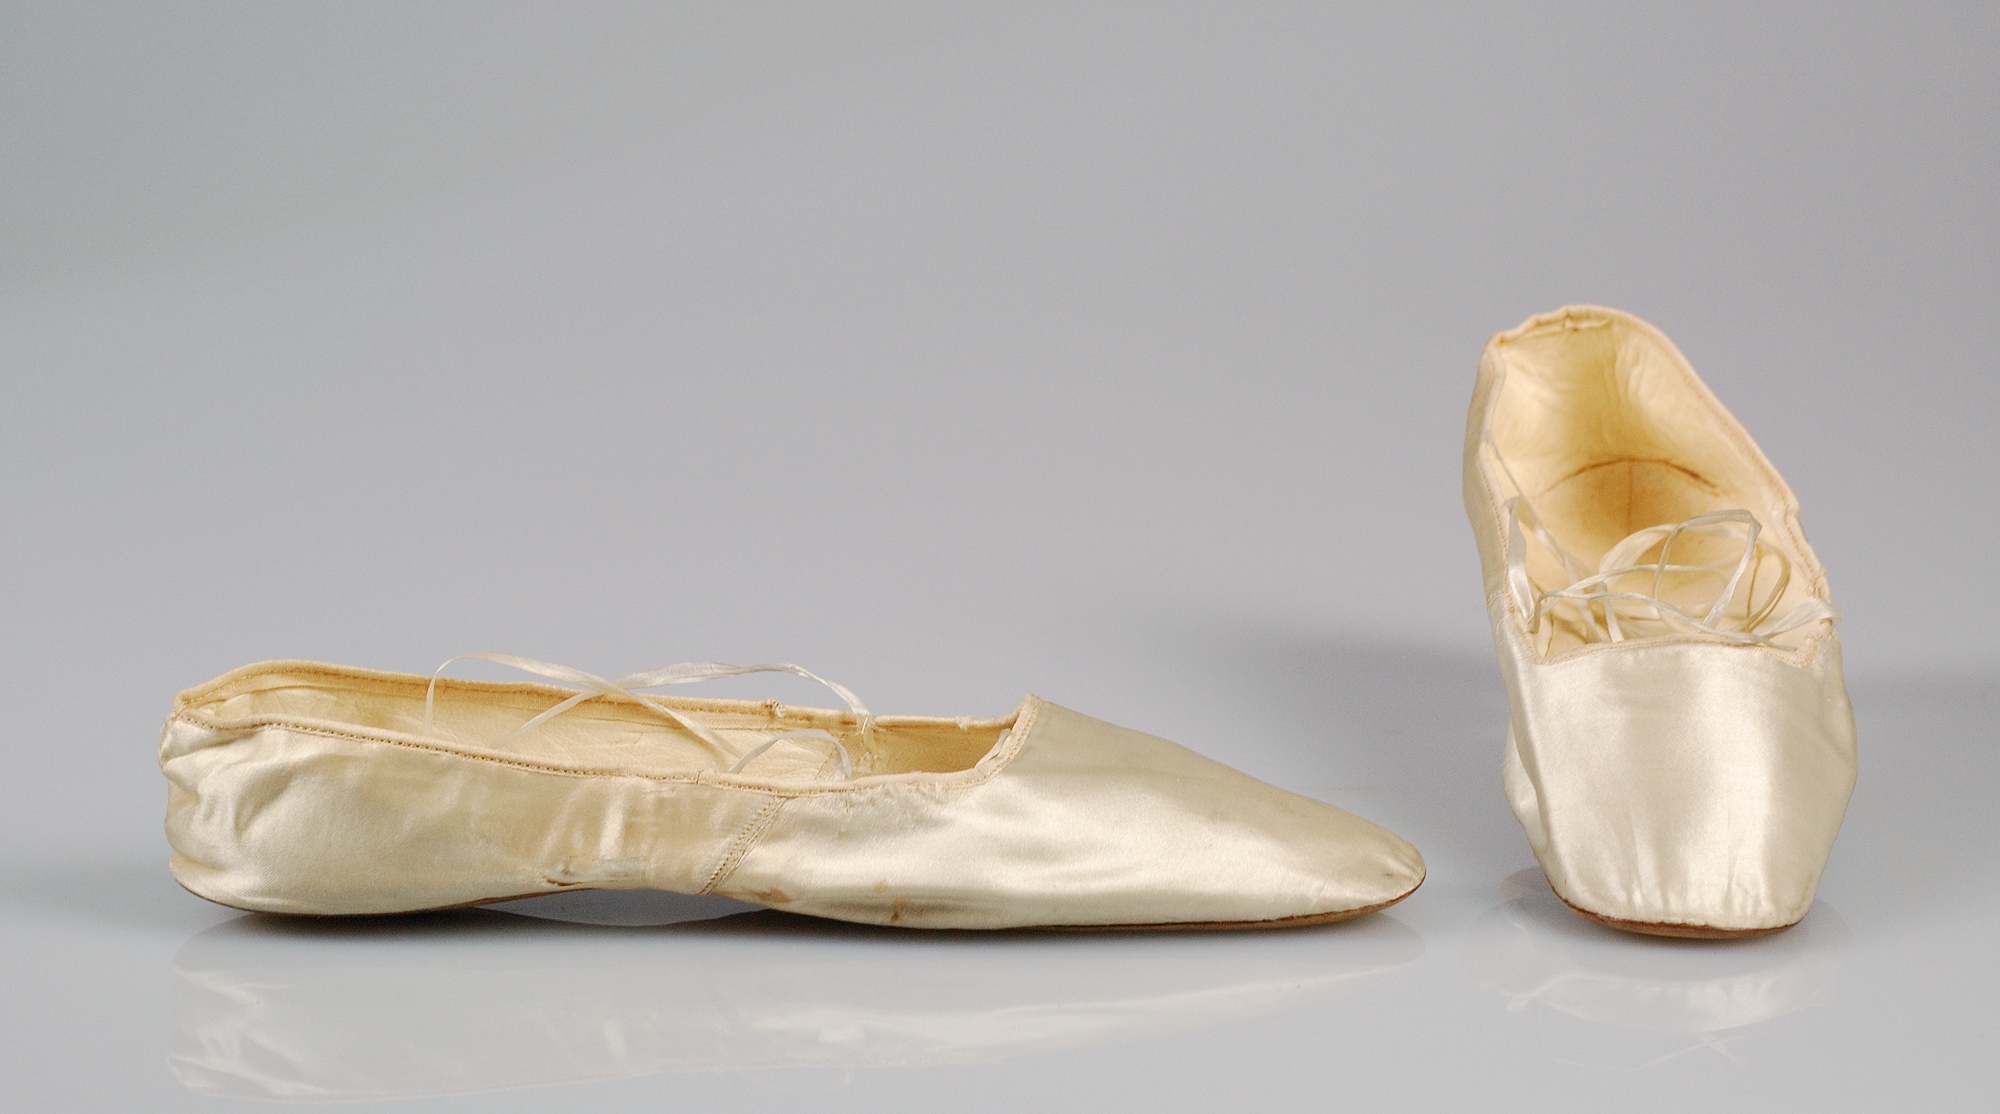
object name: wedding slipper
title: Wedding slippers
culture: american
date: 1856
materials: silk